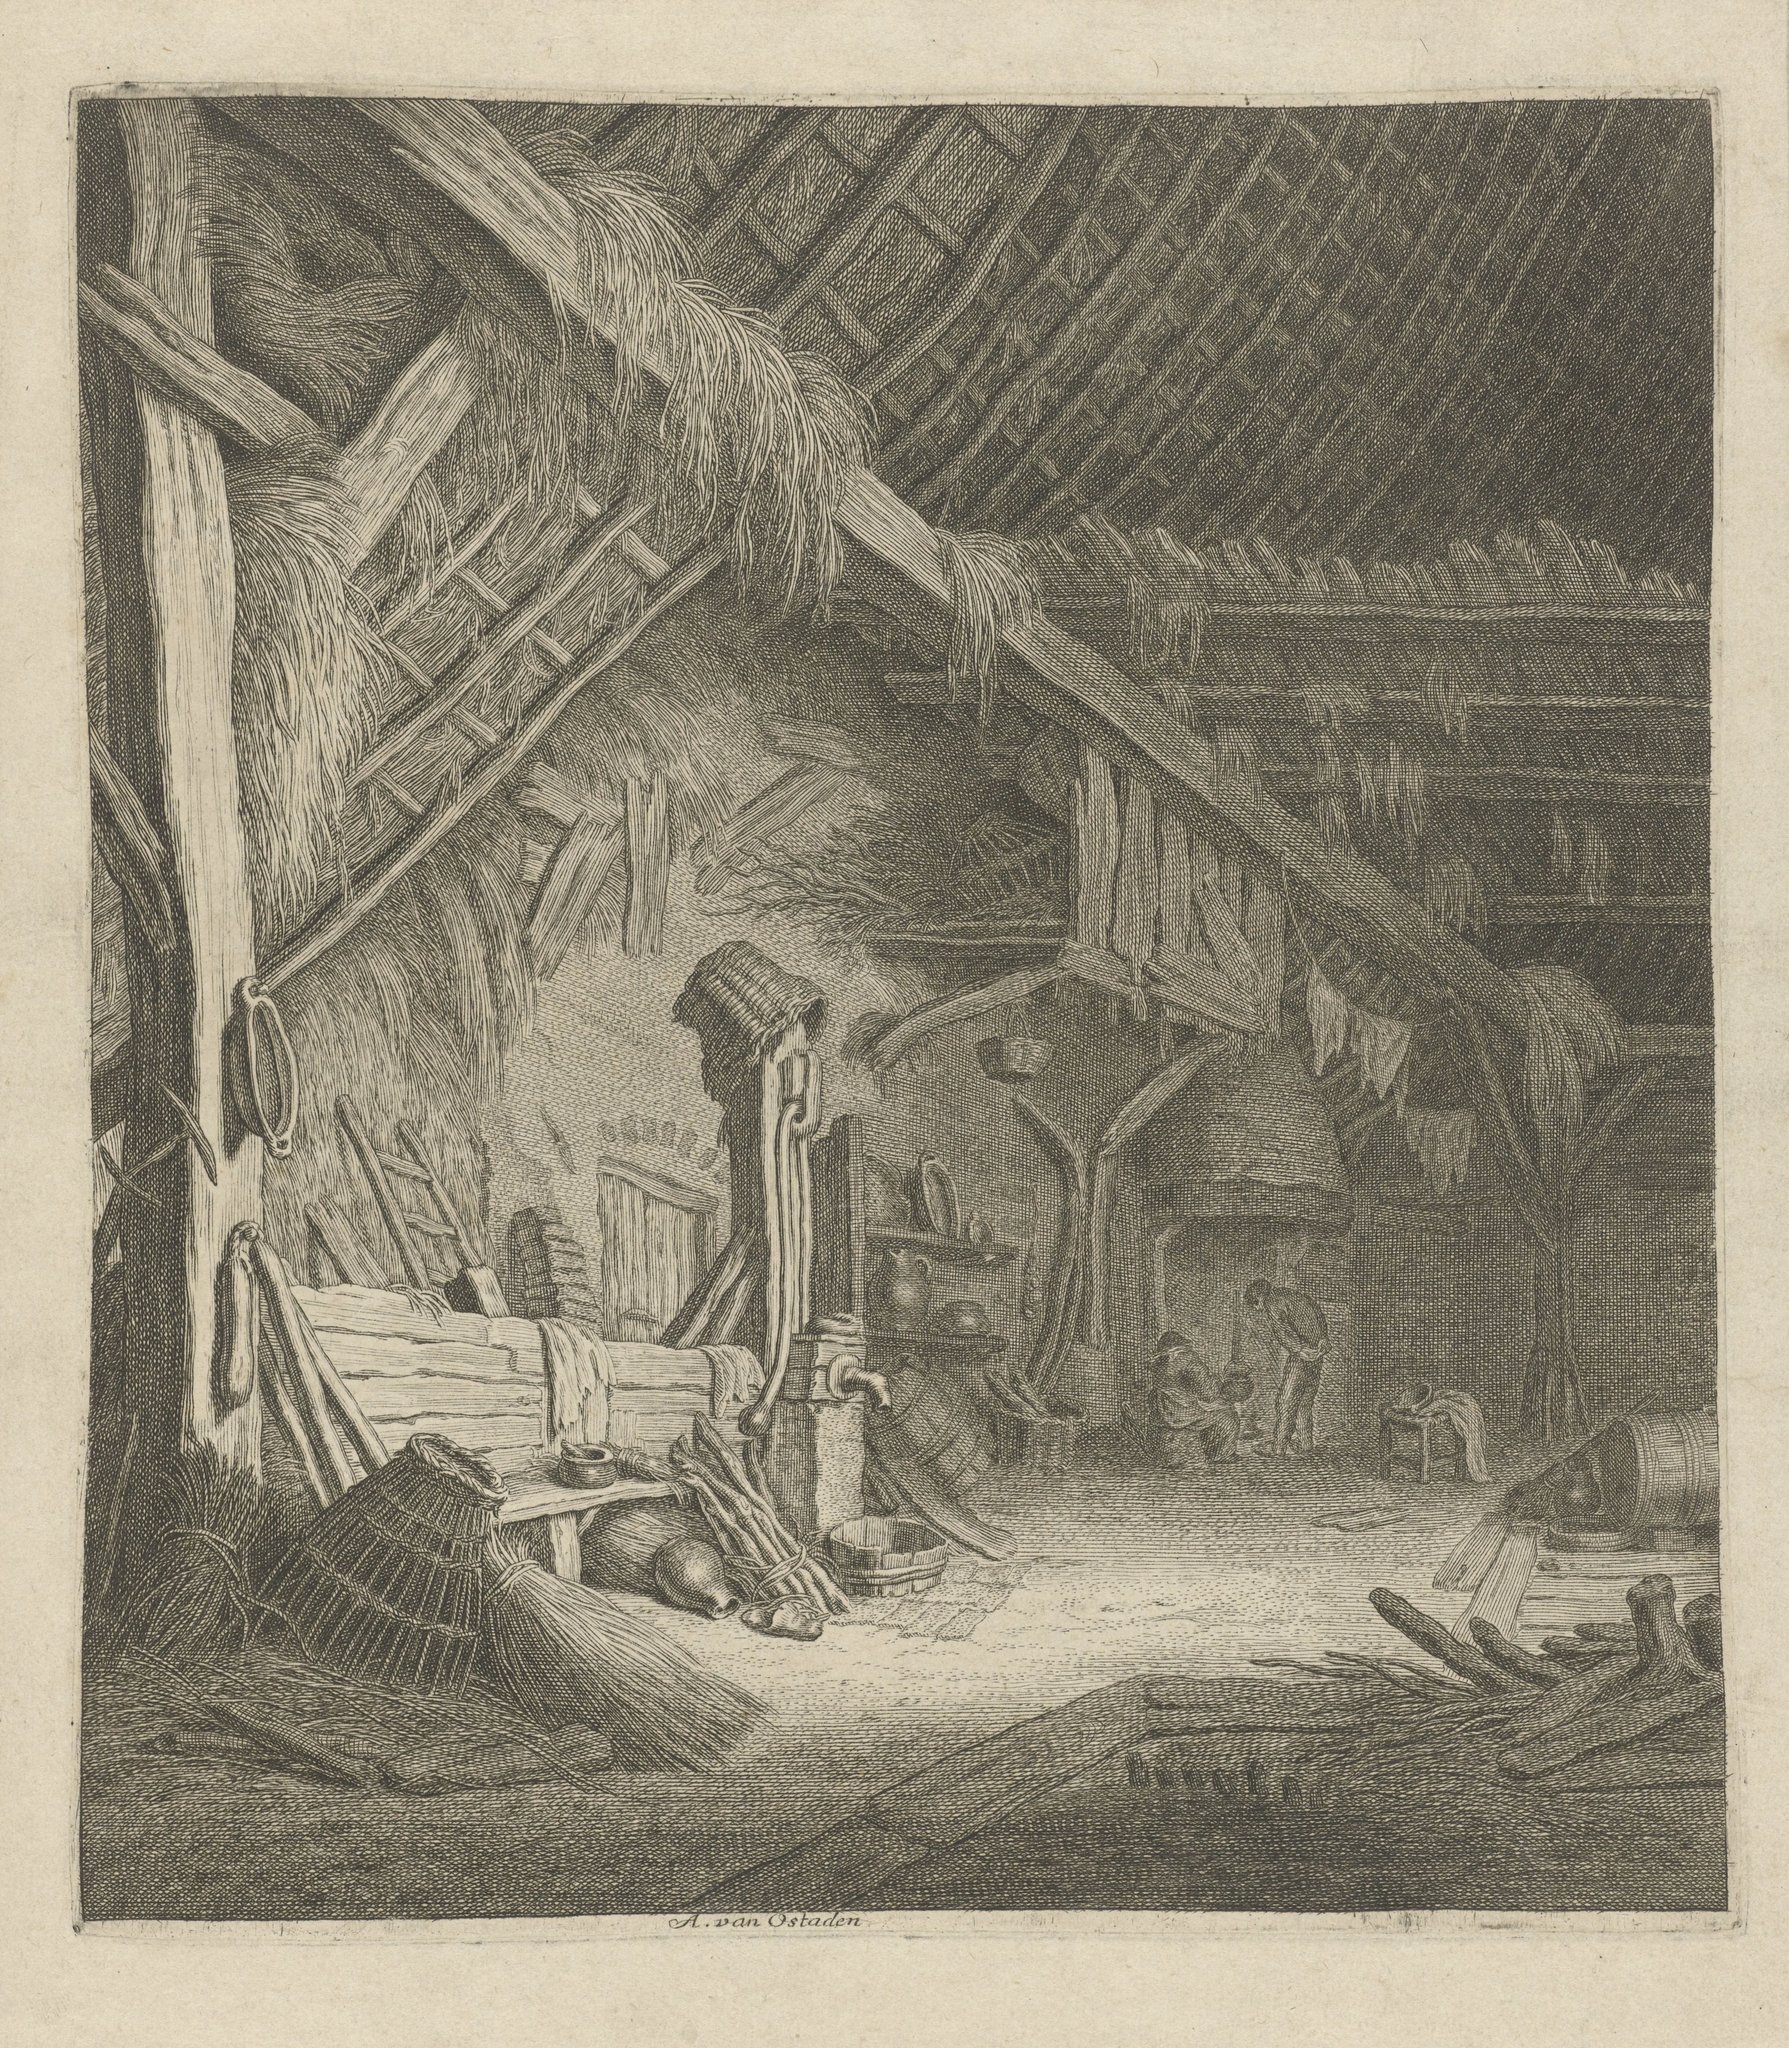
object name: print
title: Interieur van een boerderij met boer en boerin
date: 1630-1673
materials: paper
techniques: etching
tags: farm (building) - aa - civic architecture: inside, open fire, fire-place, stove (in kitchen)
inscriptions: collector's mark: Lugt 240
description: Interieur van een boerderij met een boer en een boerin bij de haard.